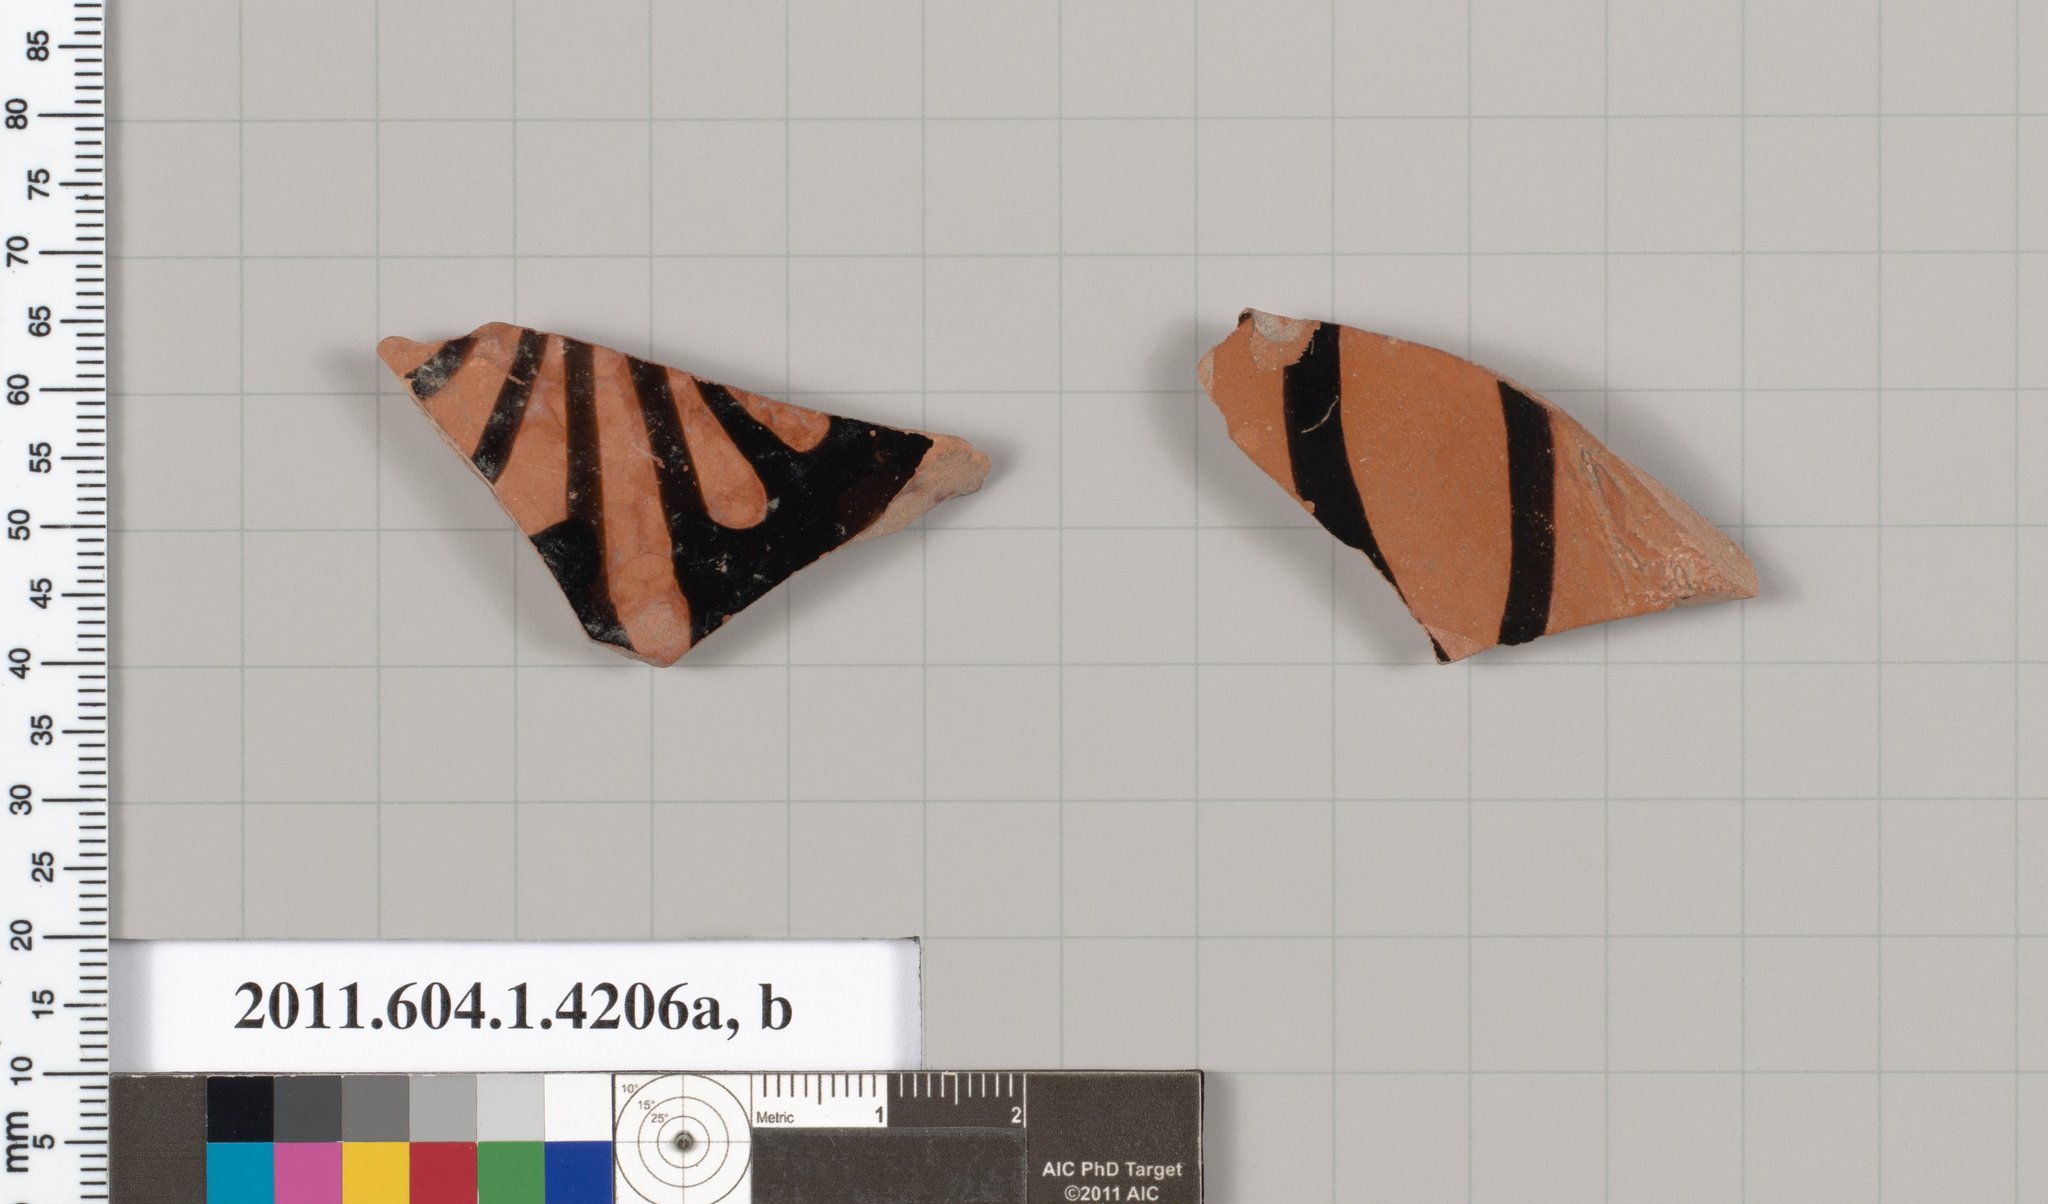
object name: kylix fragment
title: Terracotta fragments of kylikes (drinking cups)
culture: greek, attic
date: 500-451 BCE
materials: terracotta